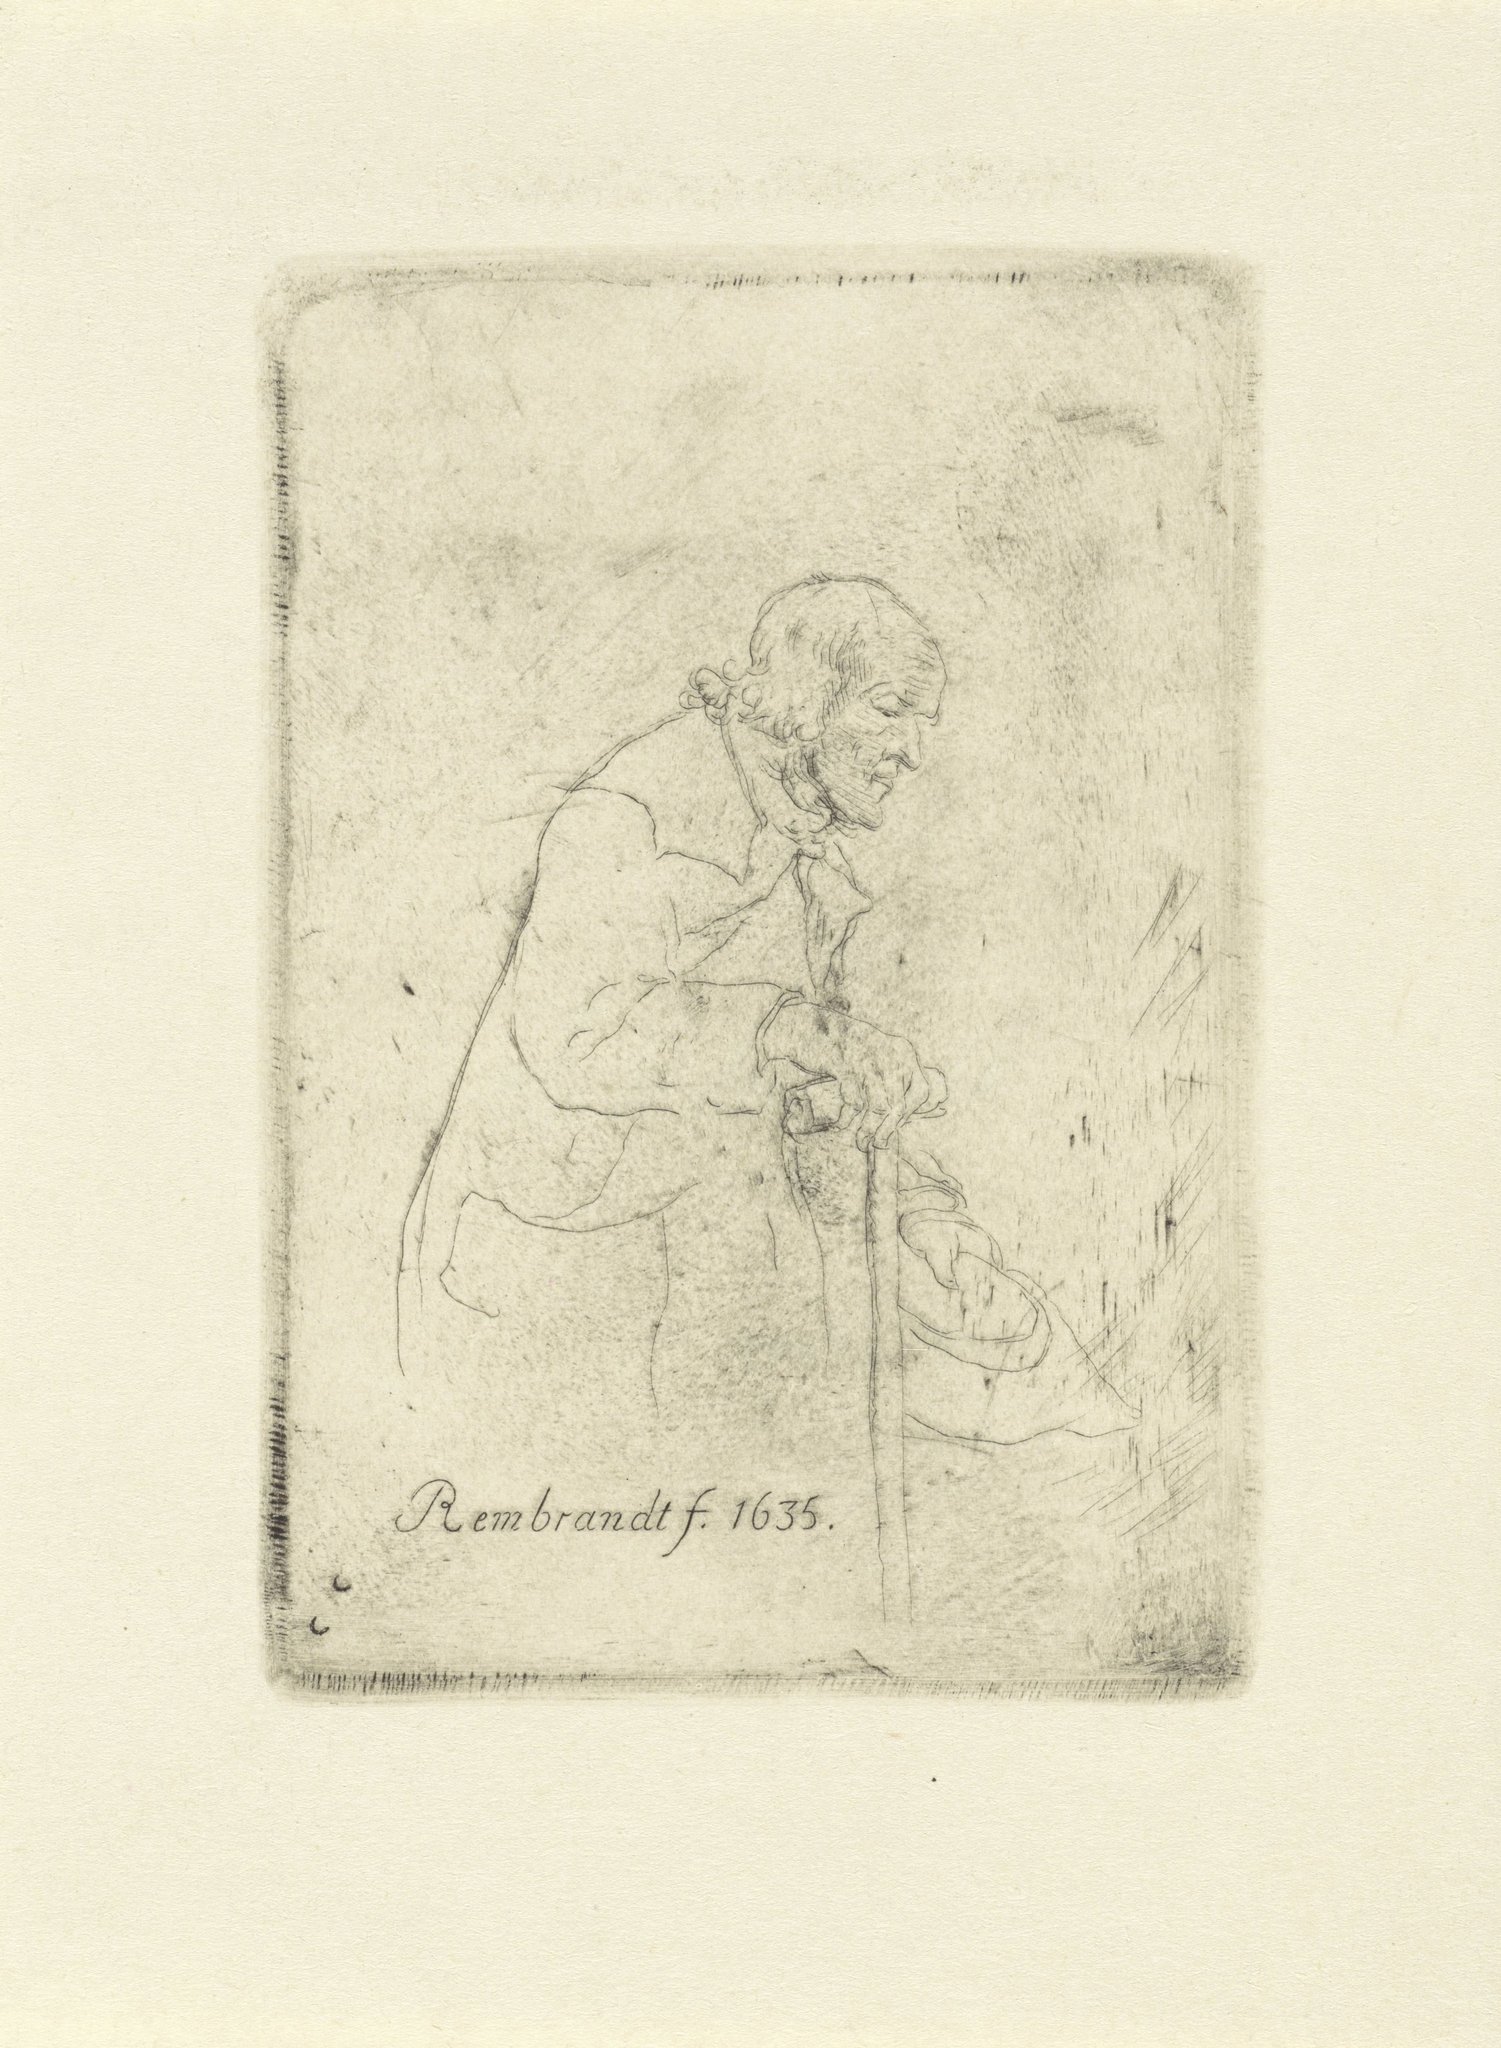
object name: print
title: Oude man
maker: Anonymous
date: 1635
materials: paper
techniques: etching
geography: low countries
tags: old man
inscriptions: collector's mark: Lugt 2228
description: Een oude man leunt op zijn stok. In zijn linkerhand heeft hij een hoed.